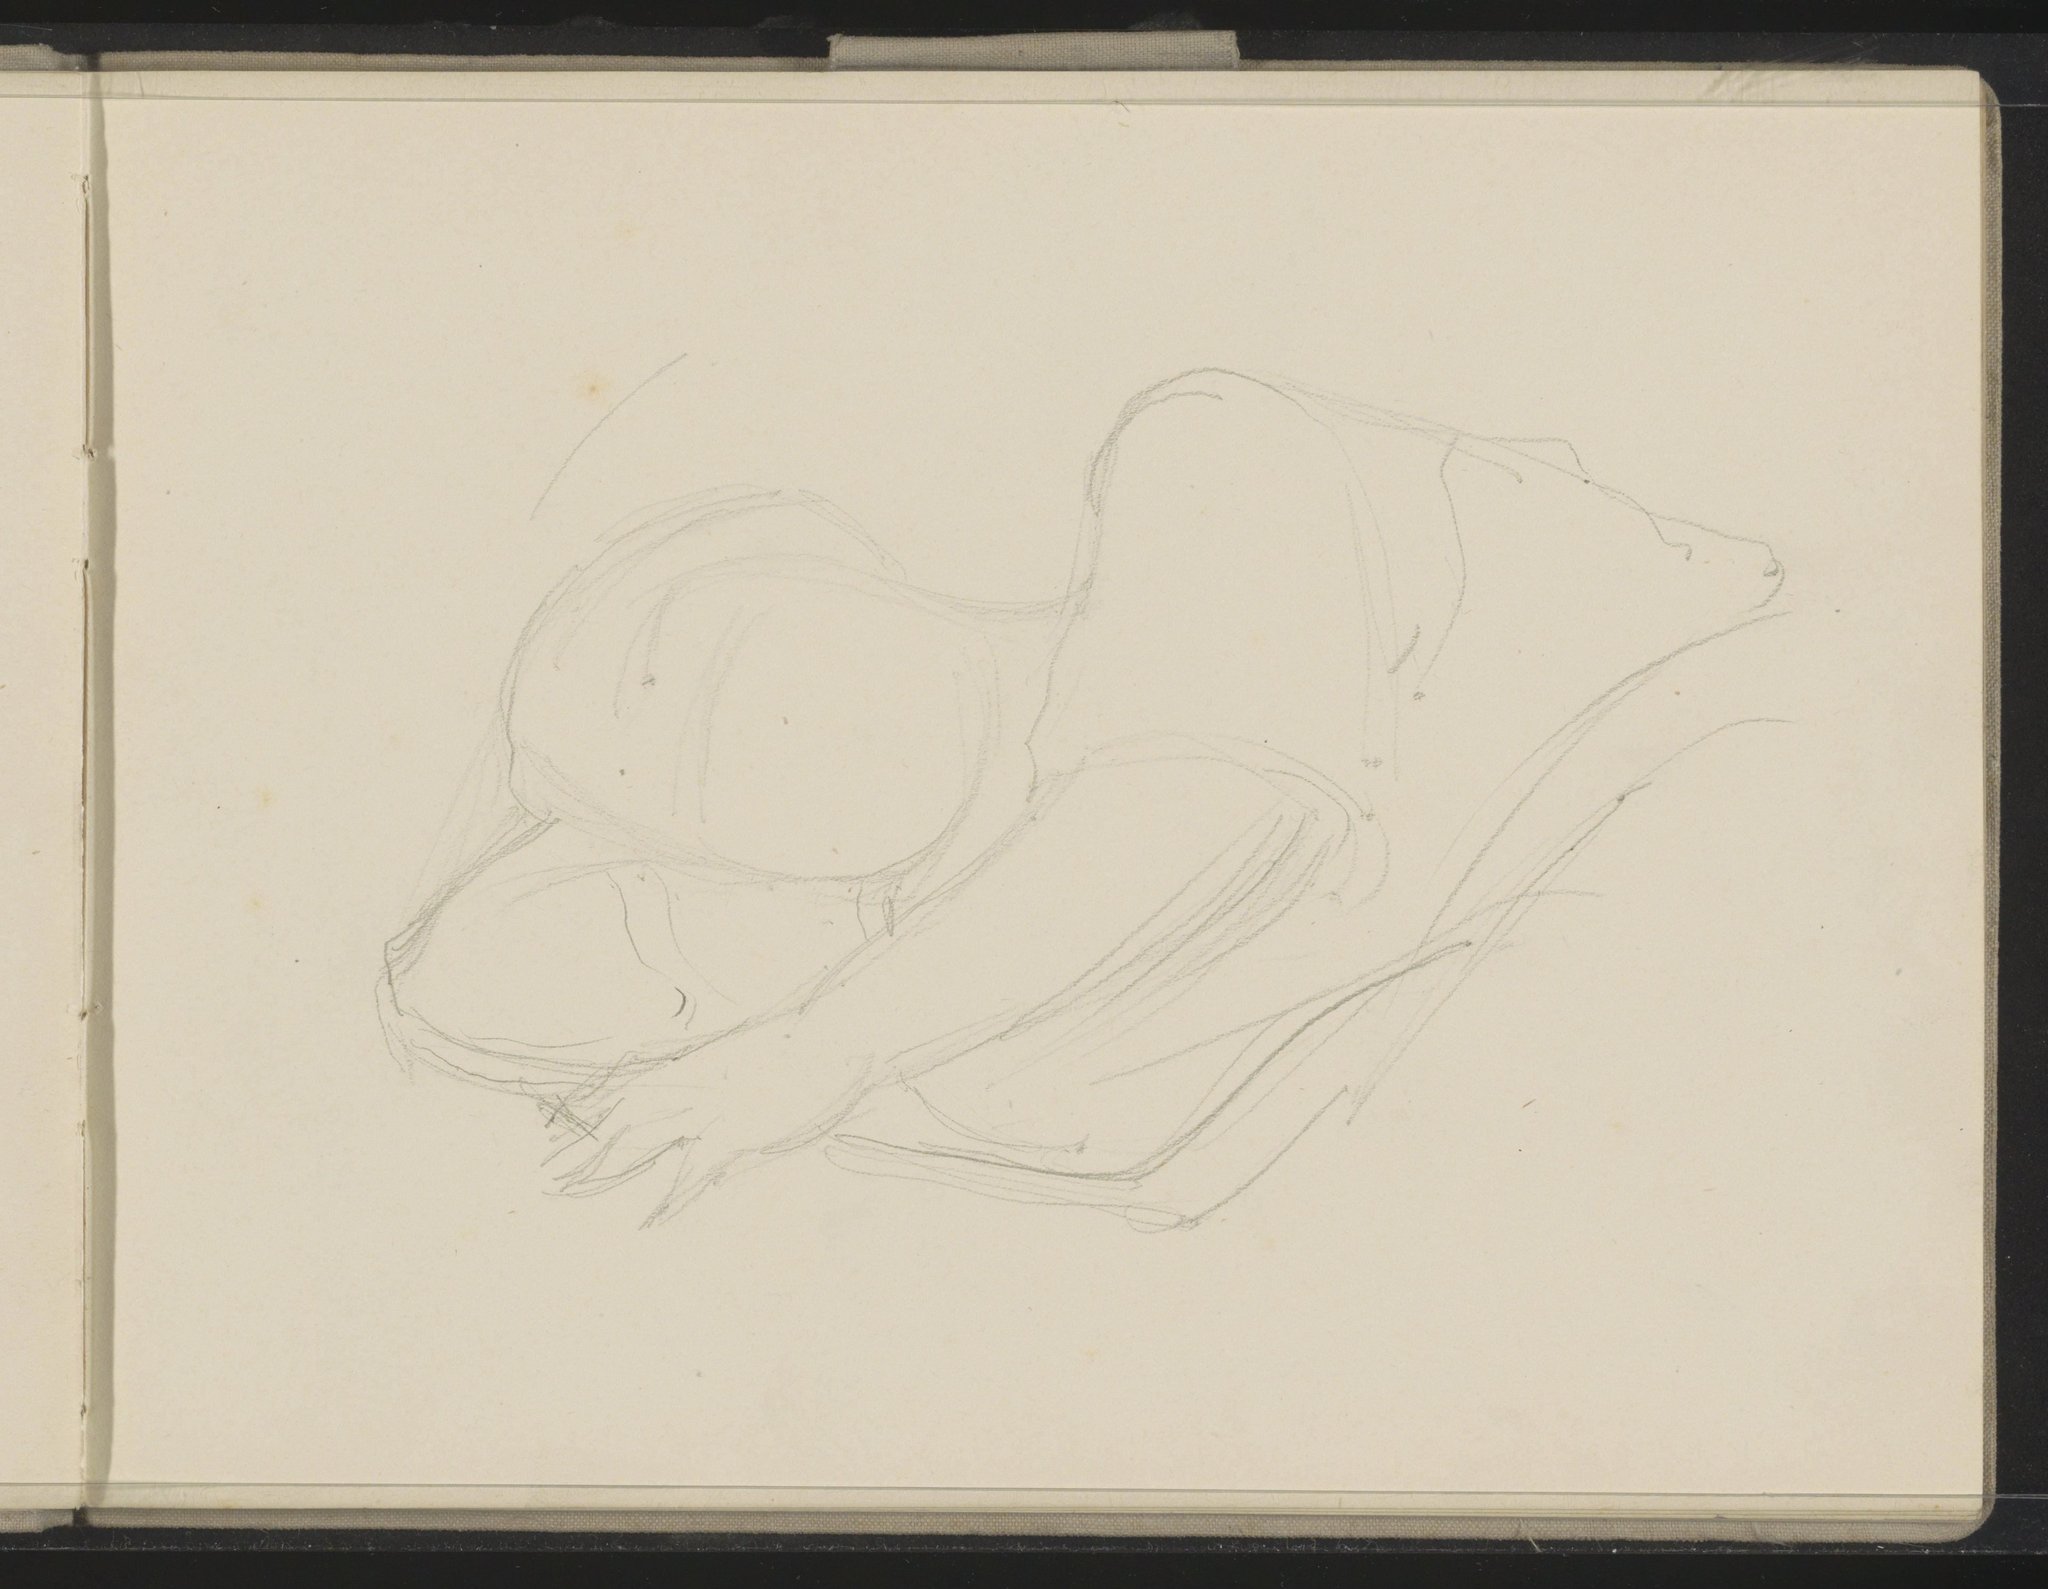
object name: sketchbook leaf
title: Rustende figuur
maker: ferdinand oldewelt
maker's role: draughtsman, print maker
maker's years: 1857-1935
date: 1908-1923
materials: paper, pencil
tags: pillow, resting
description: De figuur heeft het hoofd op een kussen. Blad 14 recto uit een schetsboek met 35 bladen.